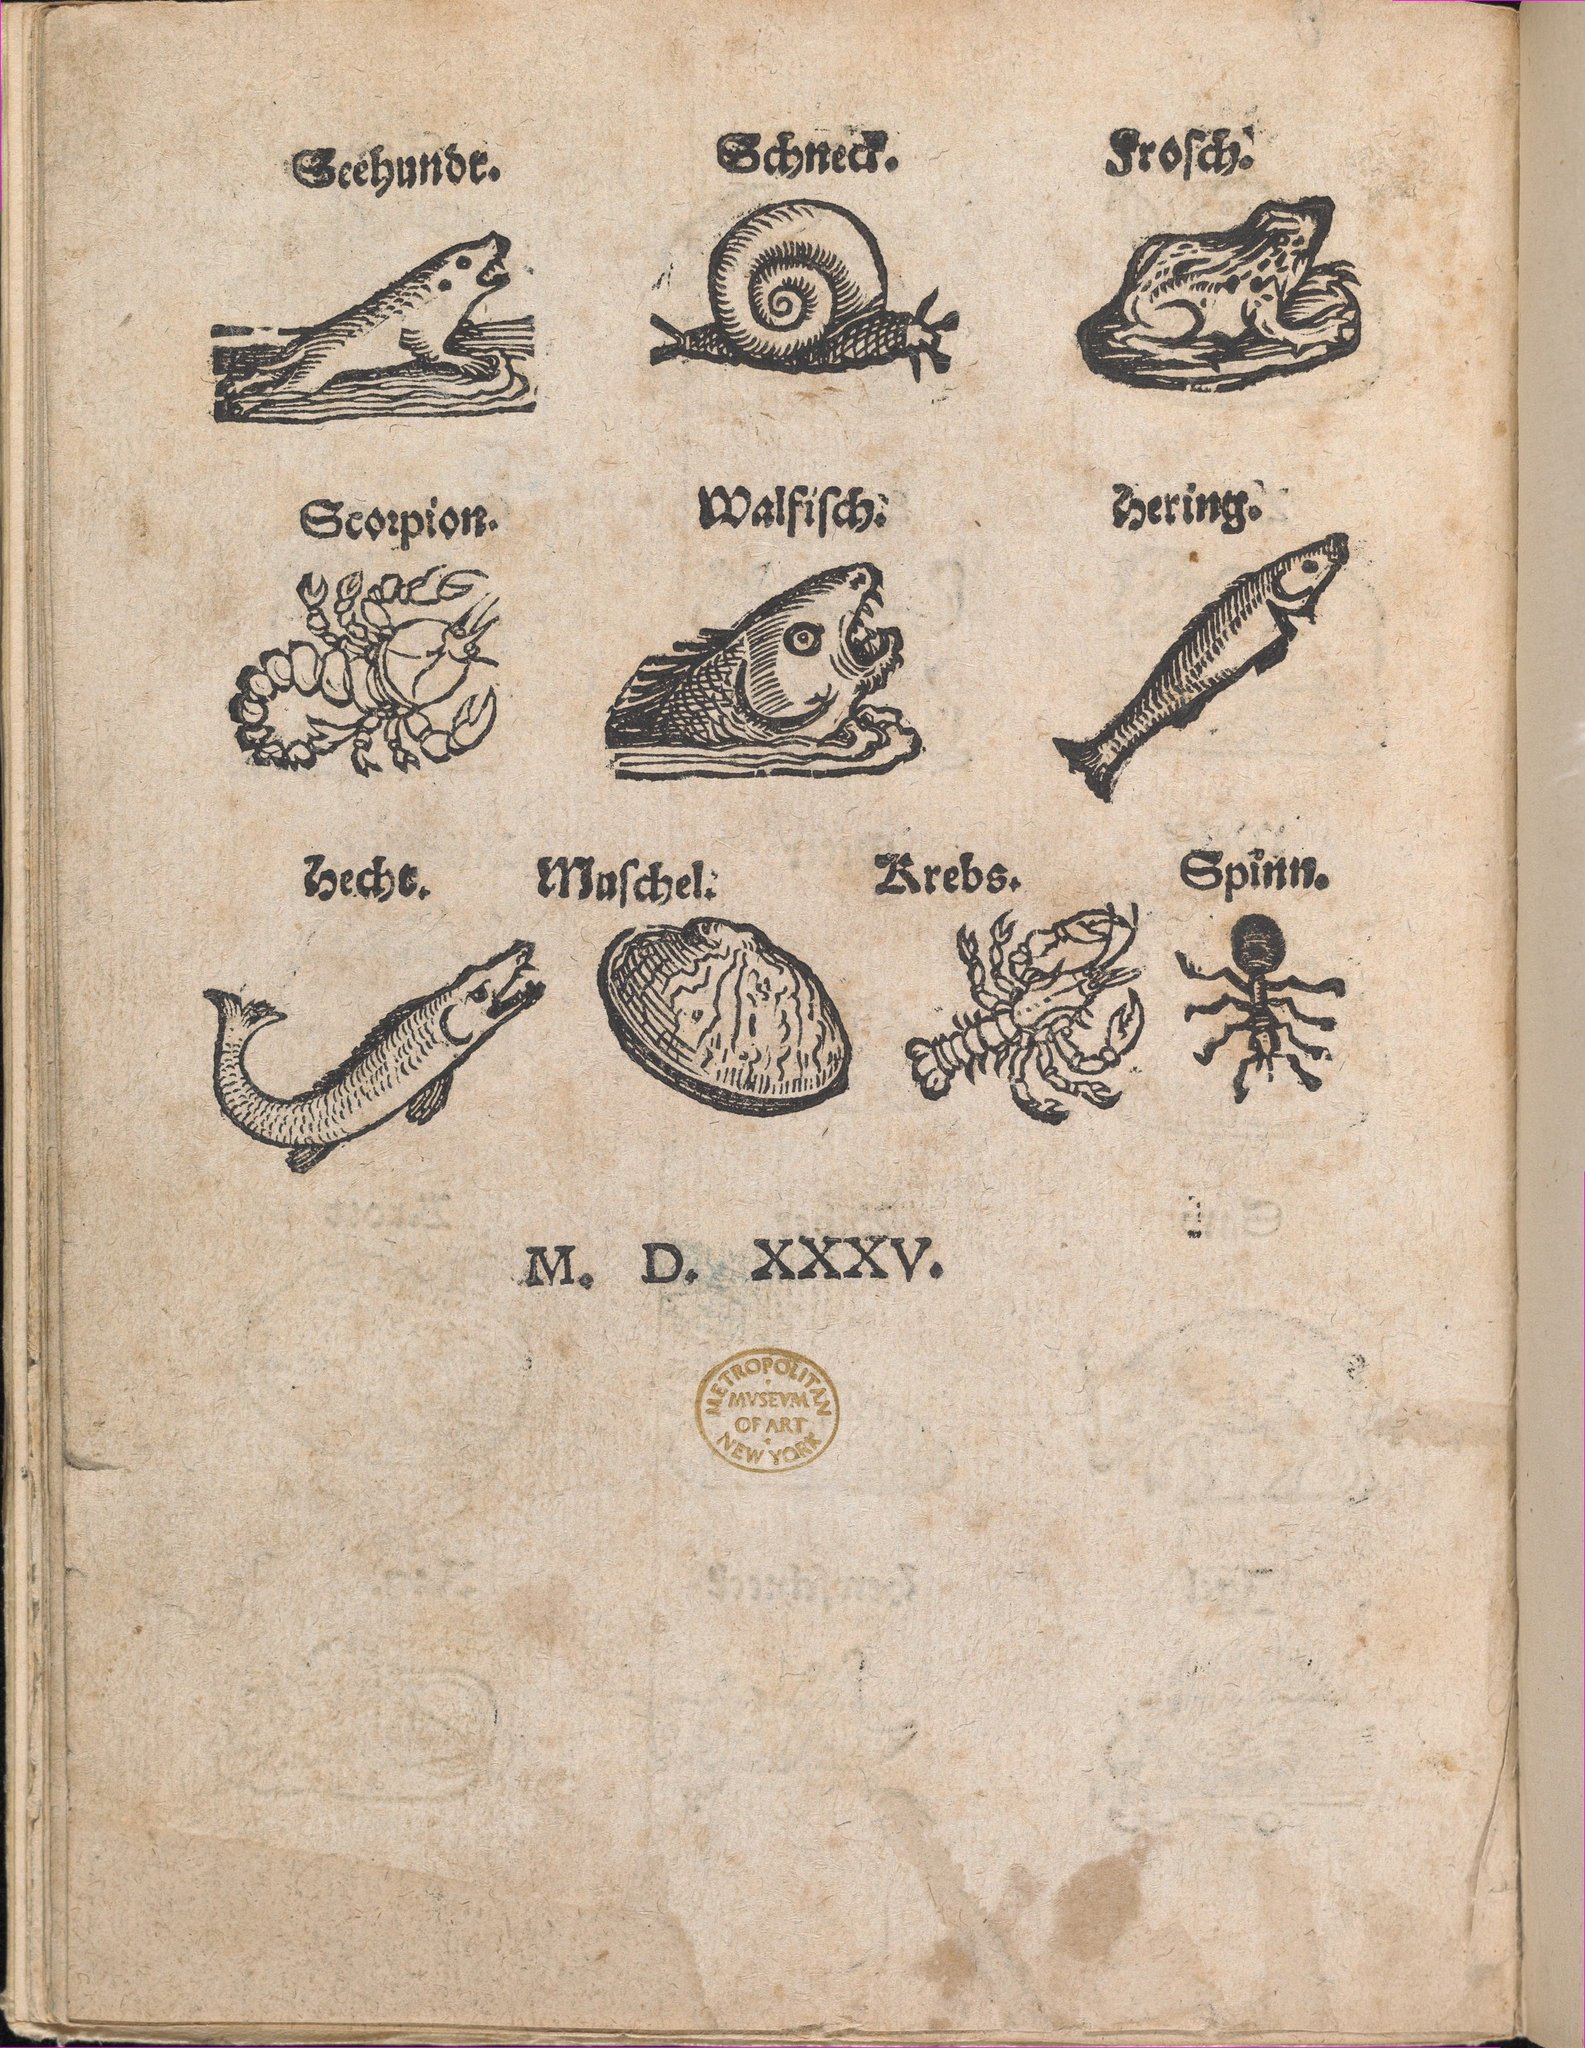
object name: ornament architecture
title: Modelbuch aller Art Nehens vn Stickens (Page 14r)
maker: christian egenolff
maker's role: publisher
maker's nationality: german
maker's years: 1502-1555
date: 1535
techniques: woodcut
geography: germany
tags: fish,frogs,insects,scorpions,snails